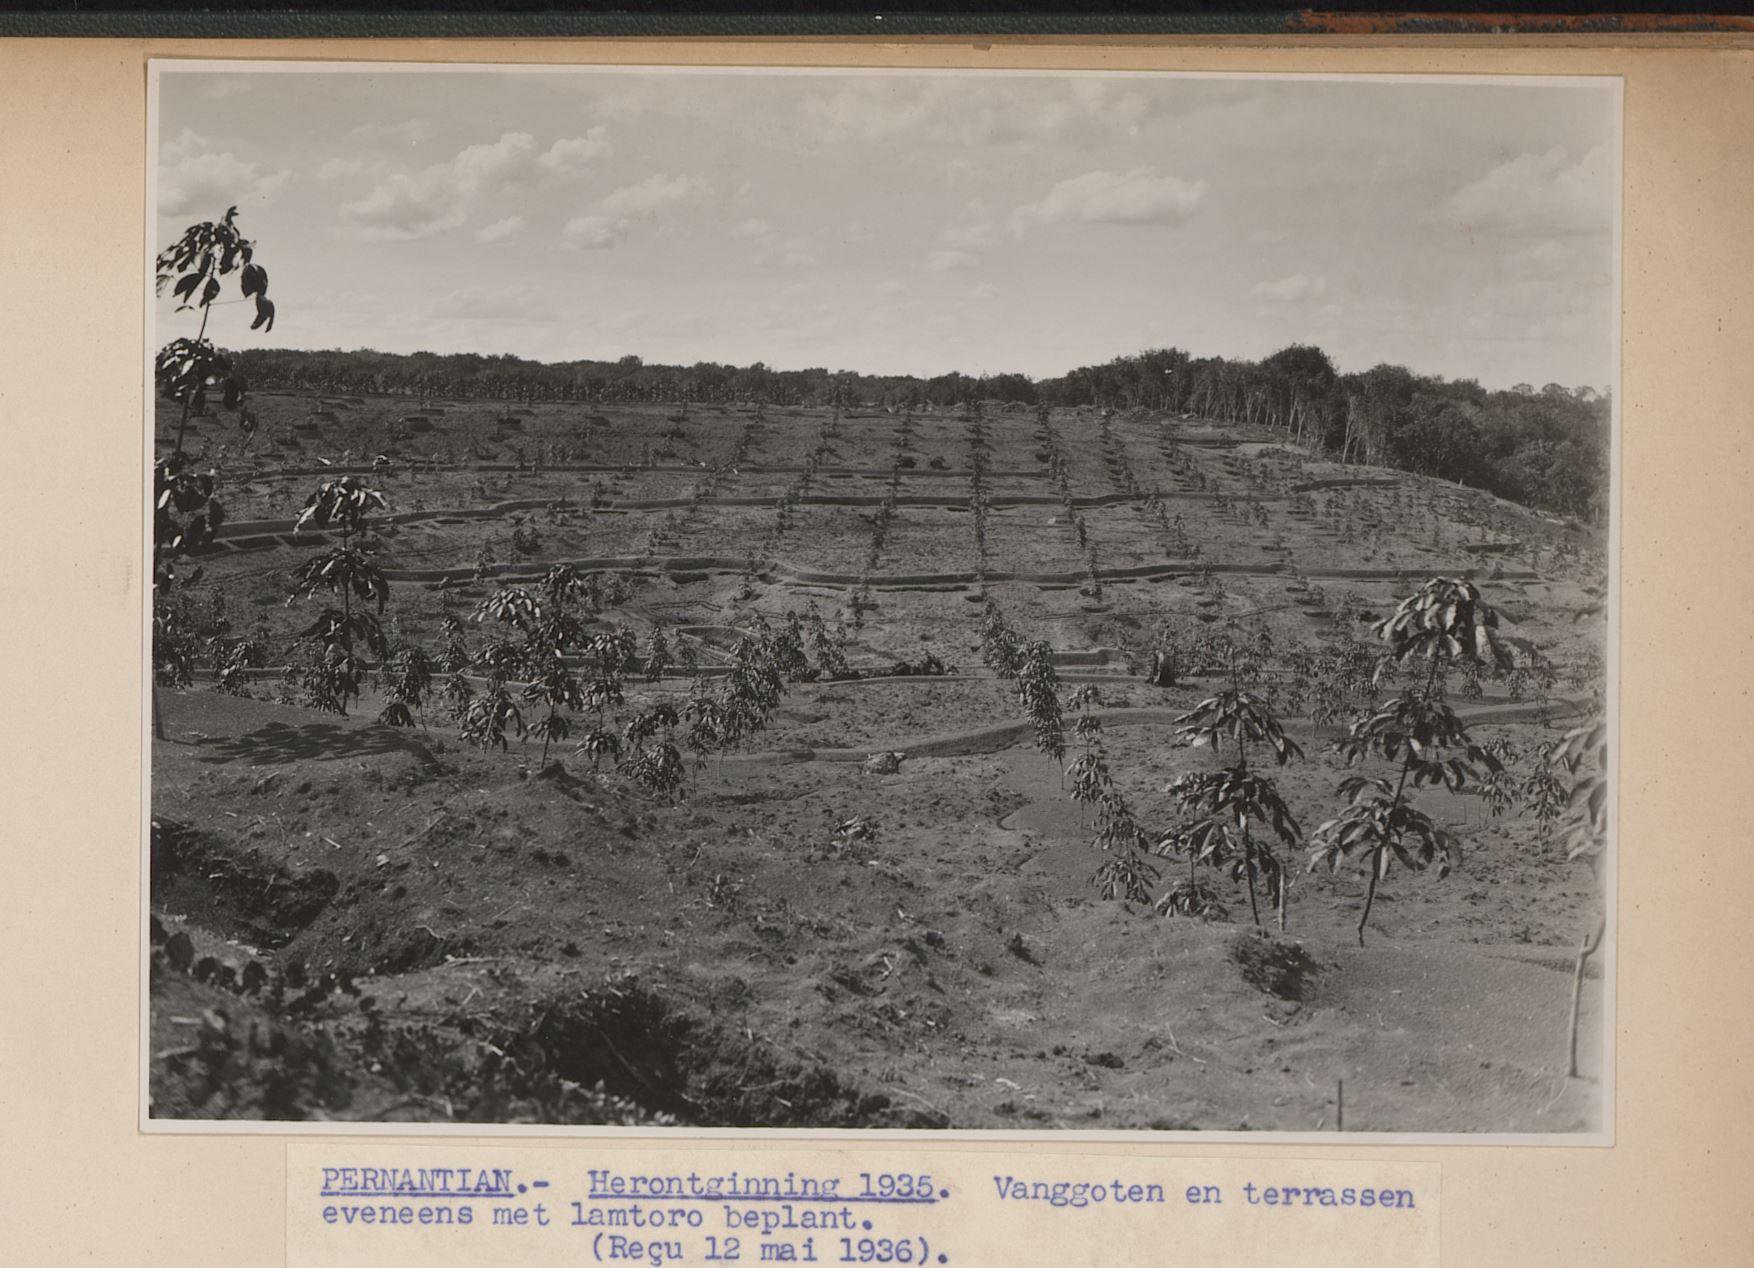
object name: photograph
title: Pernantian. - Herontginning 1935. Vanggoten en terrassen eveneens met lamtoro beplant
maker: Anonymous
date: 1936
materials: photographic support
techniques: gelatin silver print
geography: sumatra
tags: plantation, (non-fruit) products of plants or trees: rubber, sumatra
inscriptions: inscription: ‘Pernantian. - Herontginning 1935. Vanggoten en terrassen eveneens met lamtoro beplant (Reçu 12 mai 1936)’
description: Gezicht op de herontgonnen en opnieuw beplante terrassen van de plantage Pernantian in 1936. Met etiket met onderschrift onder de foto. Onderdeel van het fotoalbum over de plantages Pernantian en Brussel van de Sumatra Caoutchouc Maatschappij op de Oostkust van Sumatra in de jaren 1935-1939.